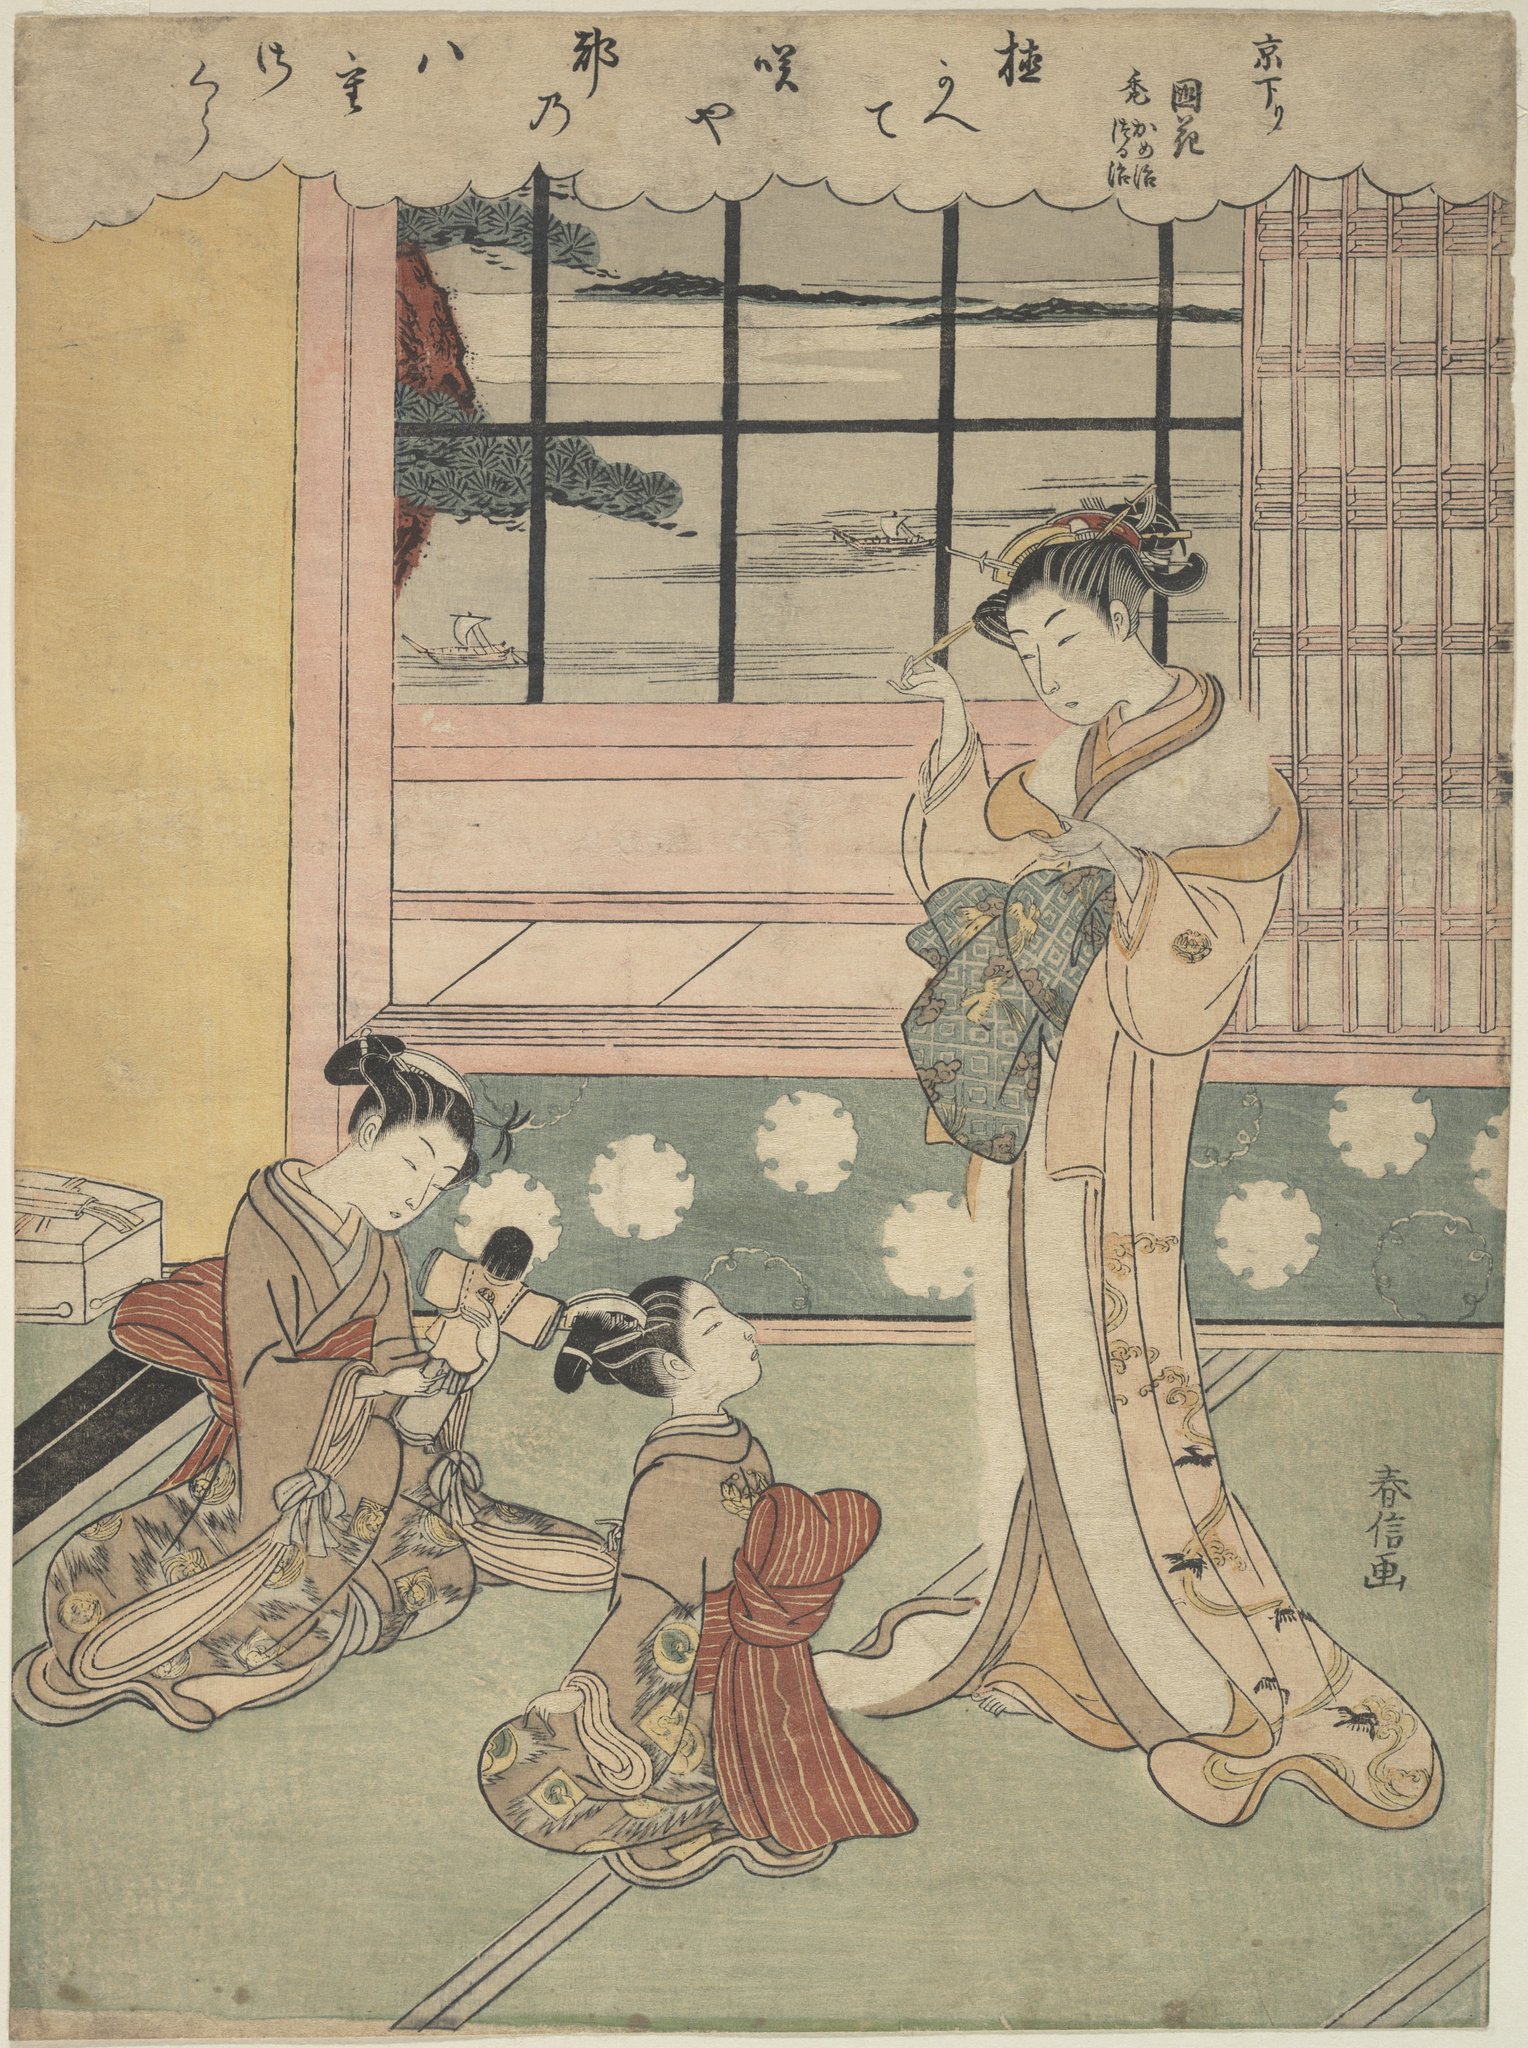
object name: print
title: Window Opening Toward the Sea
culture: japanese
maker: suzuki harunobu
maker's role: artist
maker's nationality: japanese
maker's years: 1725-1770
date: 1725-1770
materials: ink, paper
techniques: woodblock print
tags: windows,girls,women,dolls